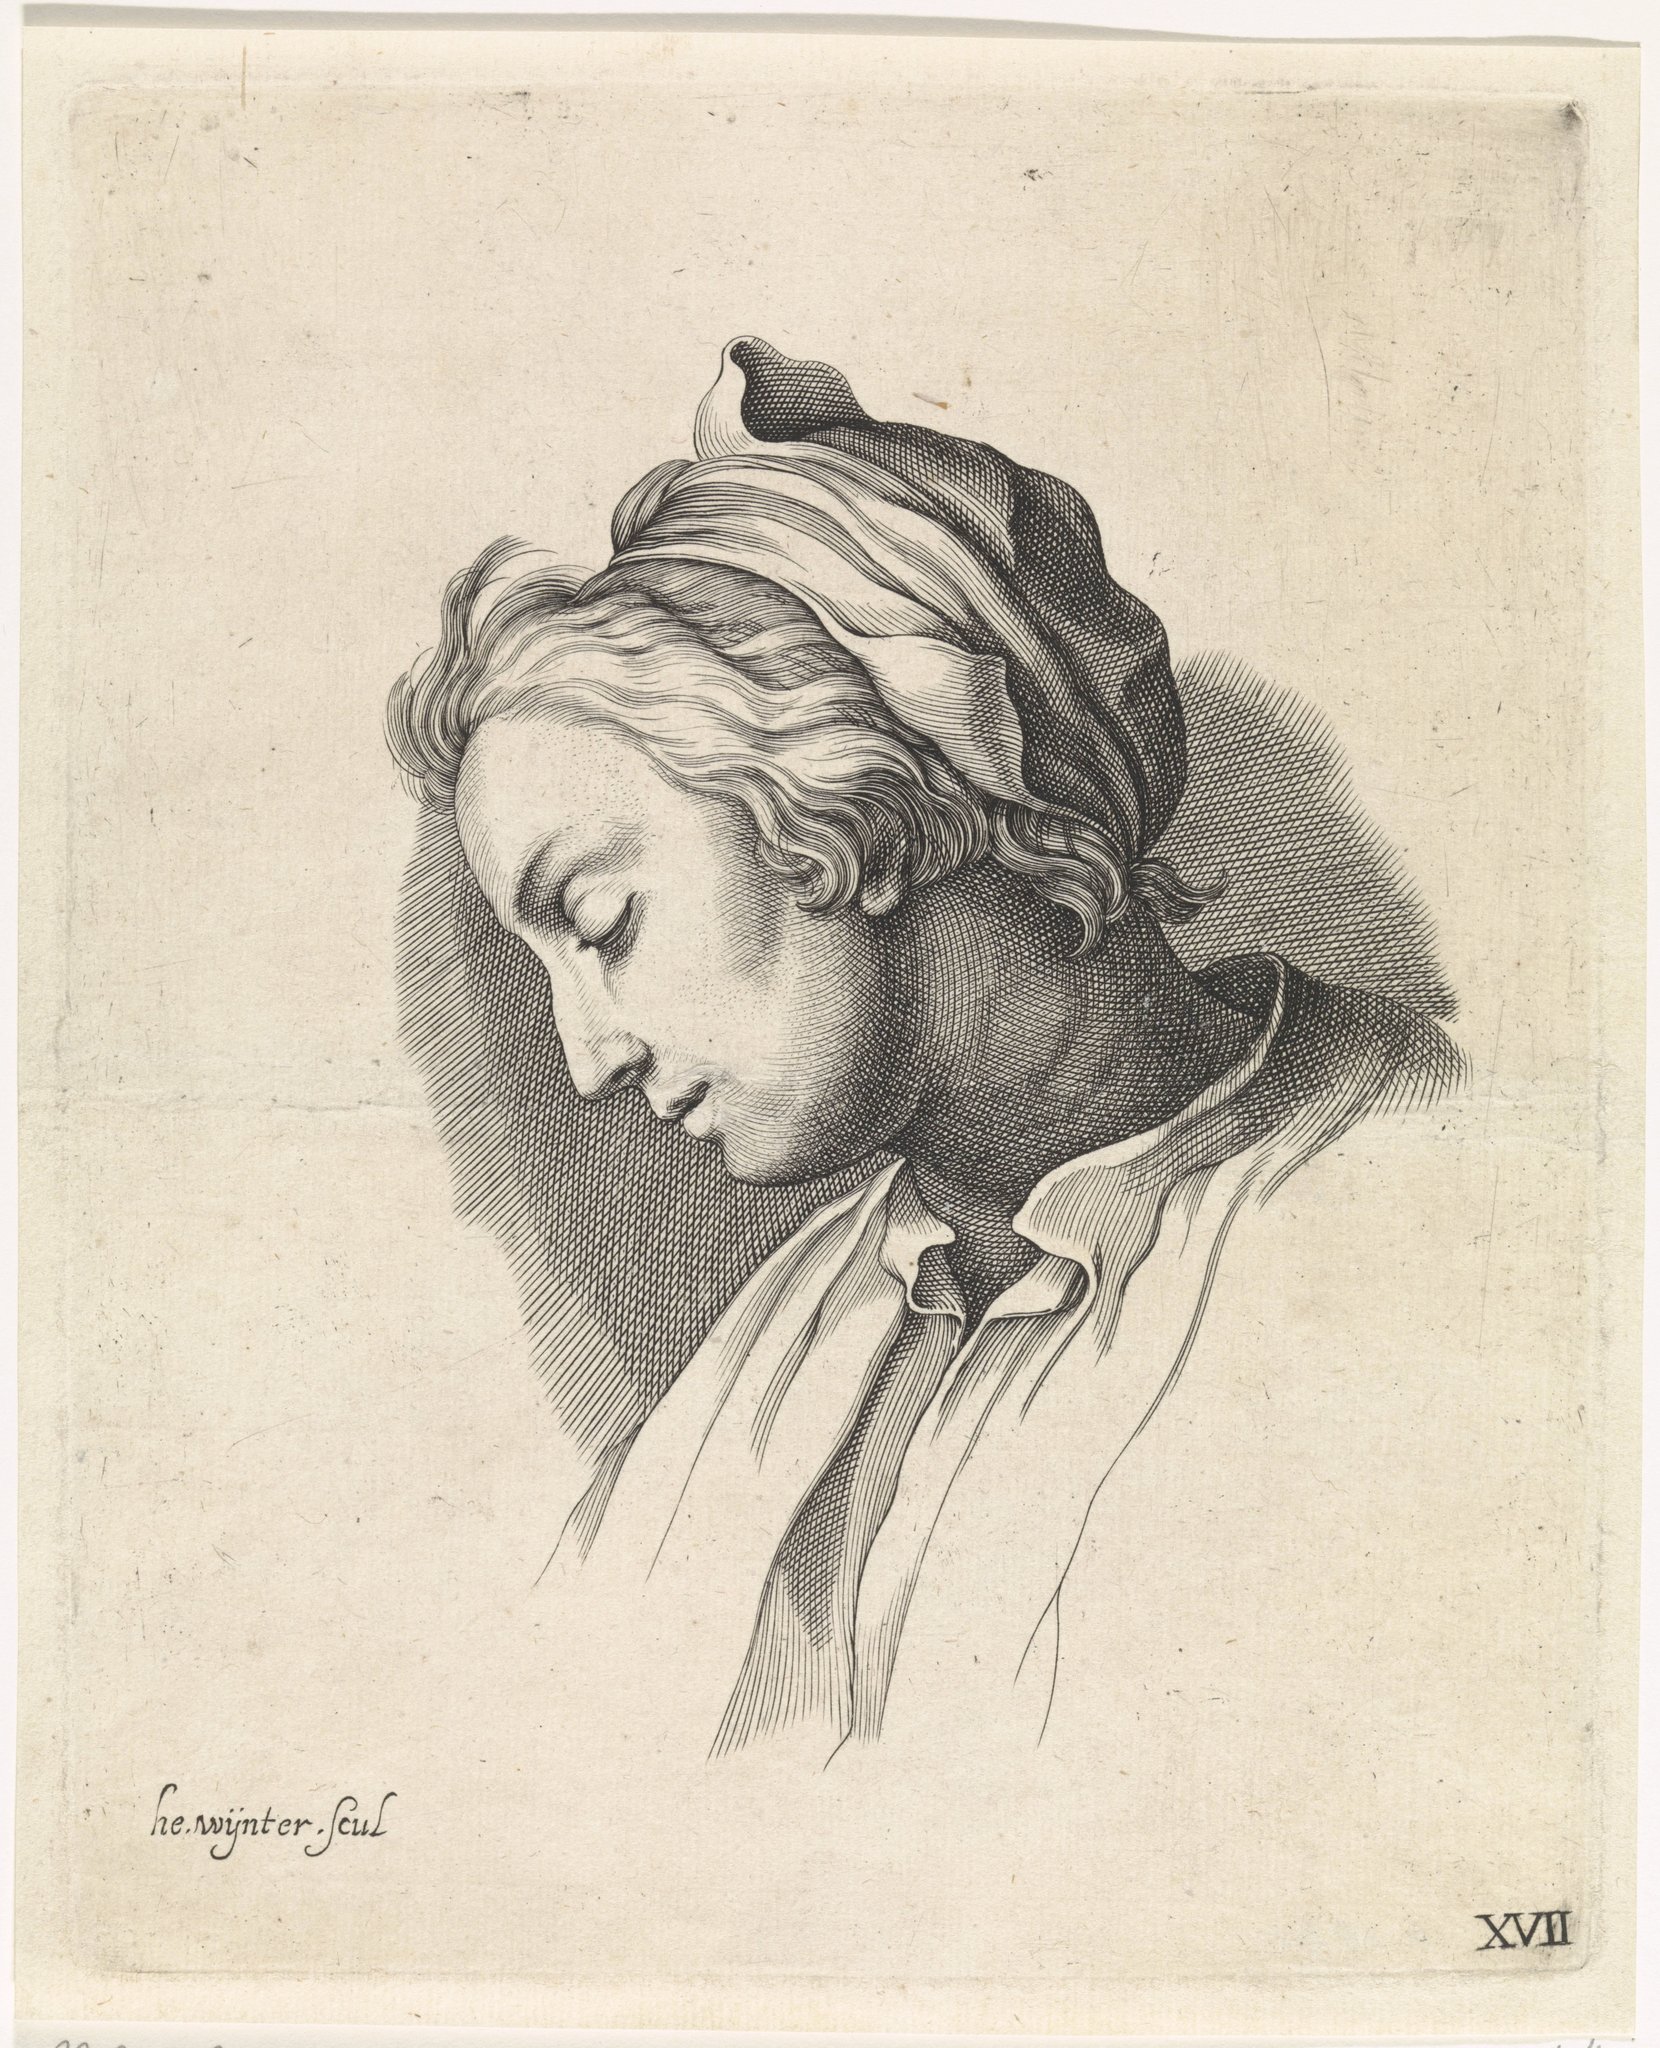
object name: print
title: Hoofd van een jonge vrouw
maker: hendrik winter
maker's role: jeweler, print maker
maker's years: 1620-1677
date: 1630-1677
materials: paper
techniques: engraving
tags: adolescent, young woman, maiden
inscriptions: collector's mark: Lugt 2228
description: Buste van een jonge vrouw, en profil, met neergeslagen ogen. Rechtsonder genummerd: XVII.